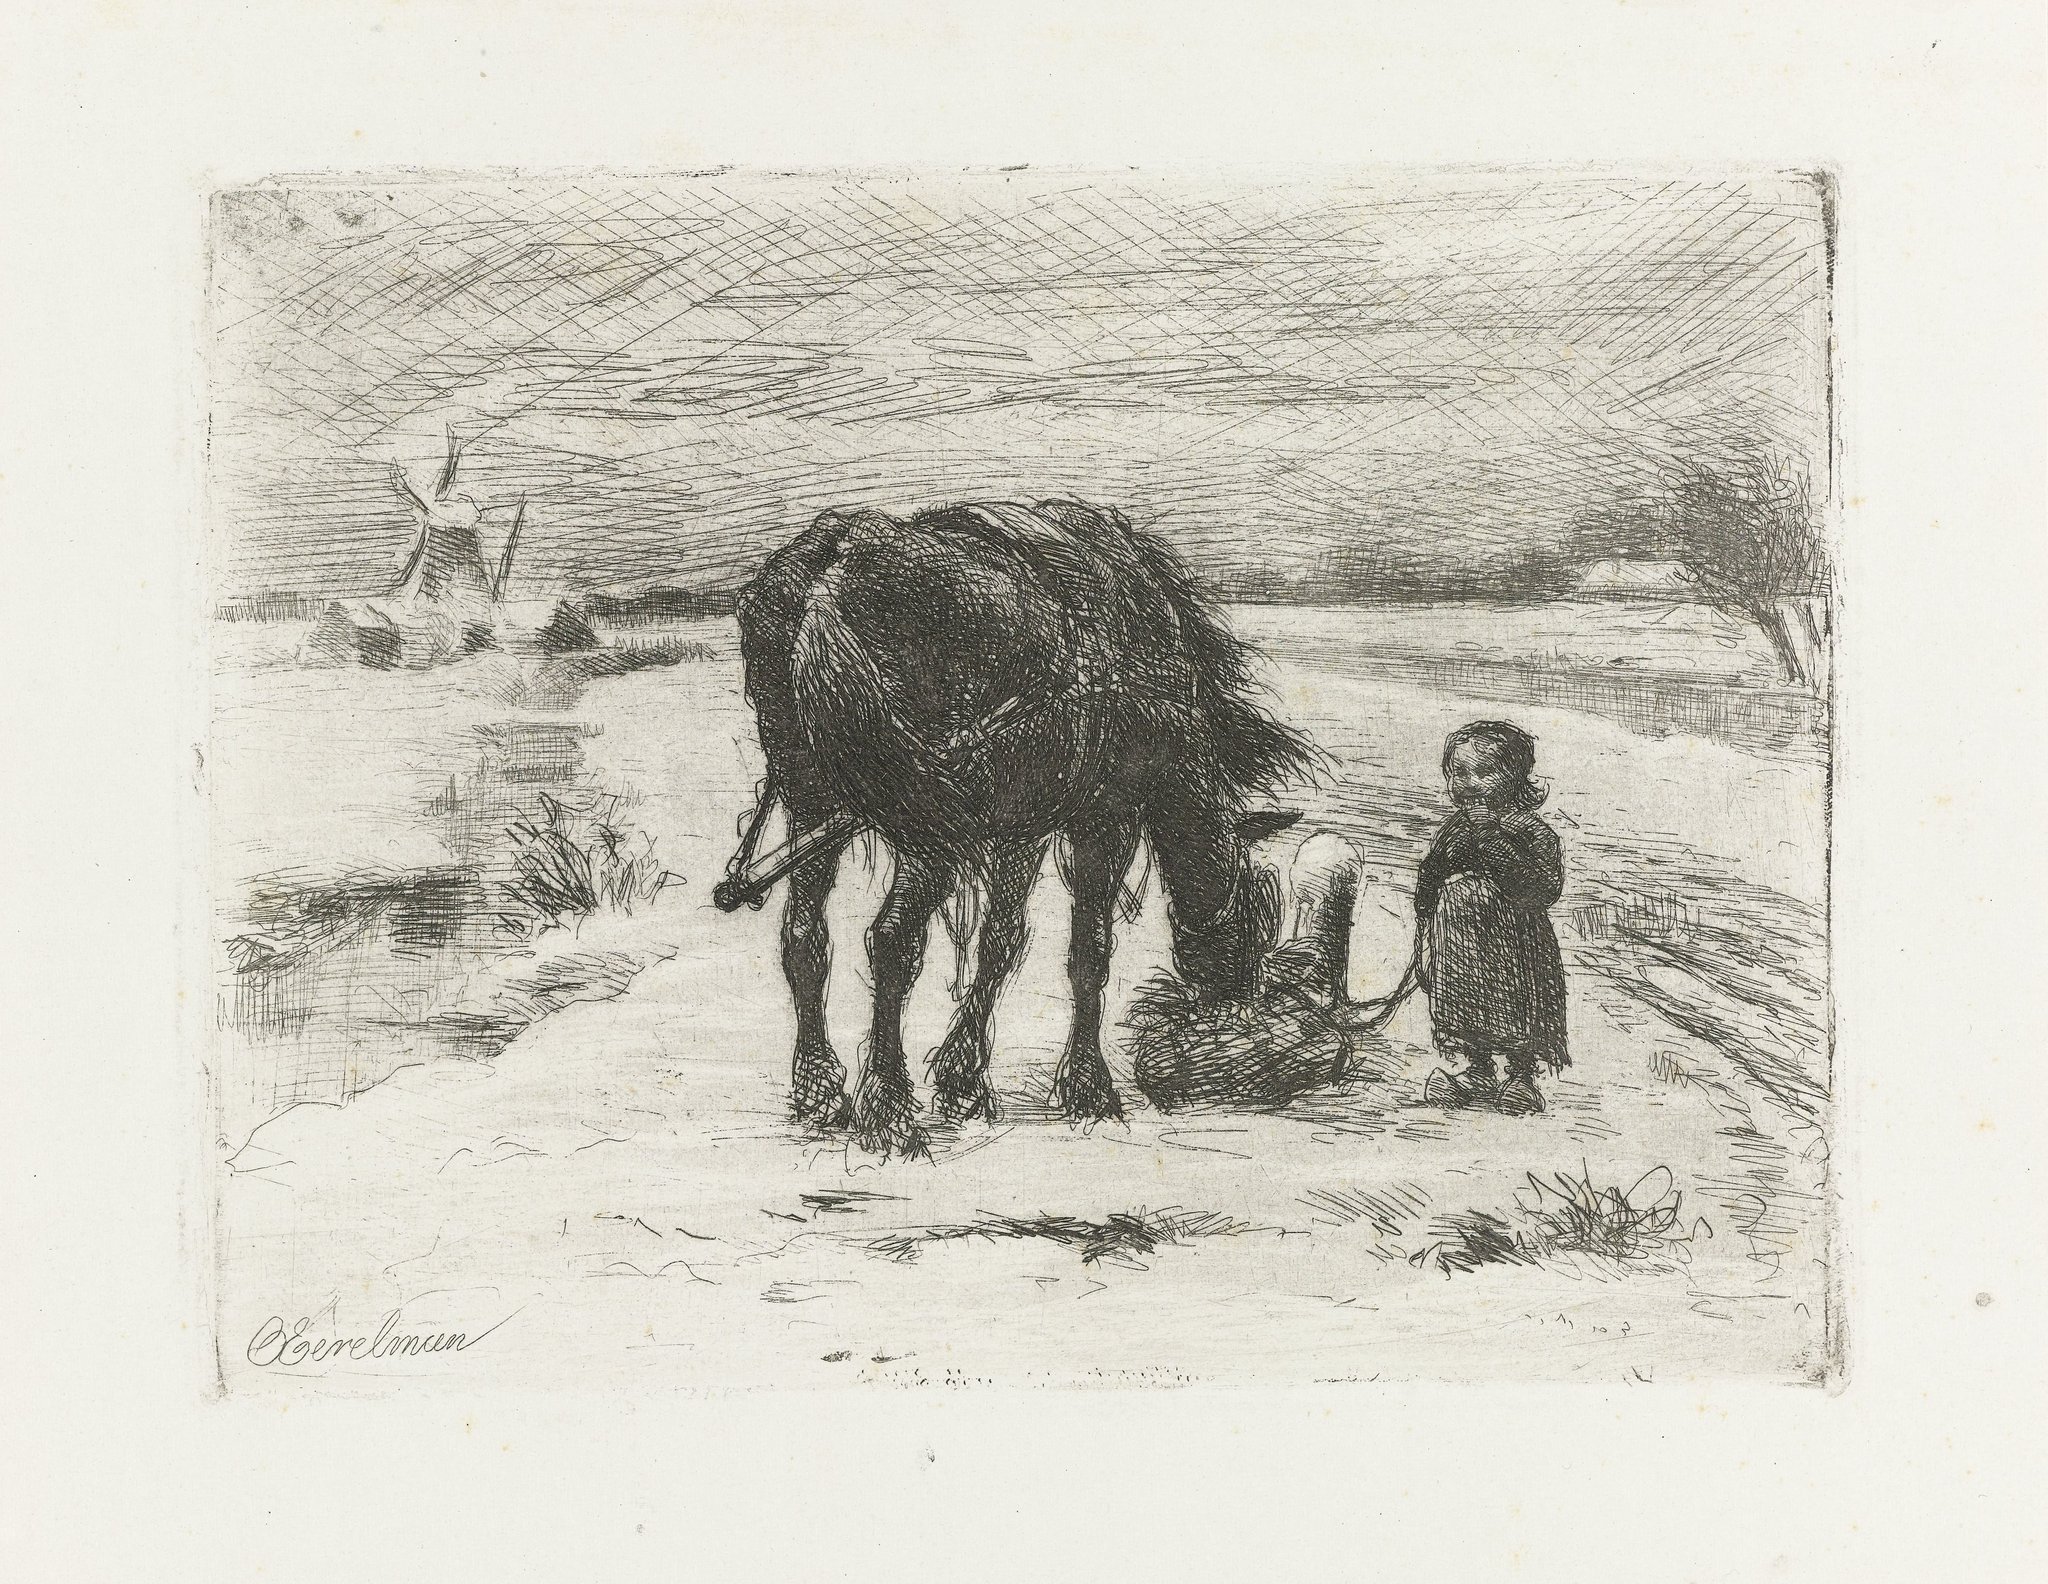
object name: print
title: Sneeuwlandschap met kind en paard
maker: otto eerelman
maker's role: draughtsman, painter, print maker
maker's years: 1839-1926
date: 1849-1892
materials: paper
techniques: etching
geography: netherlands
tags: horse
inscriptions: collector's mark: Lugt 2228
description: In een besneeuwd landschap kijkt een kind naar een paard dat uit een op de grond liggende zak eet. Op de achtergrond een molen.